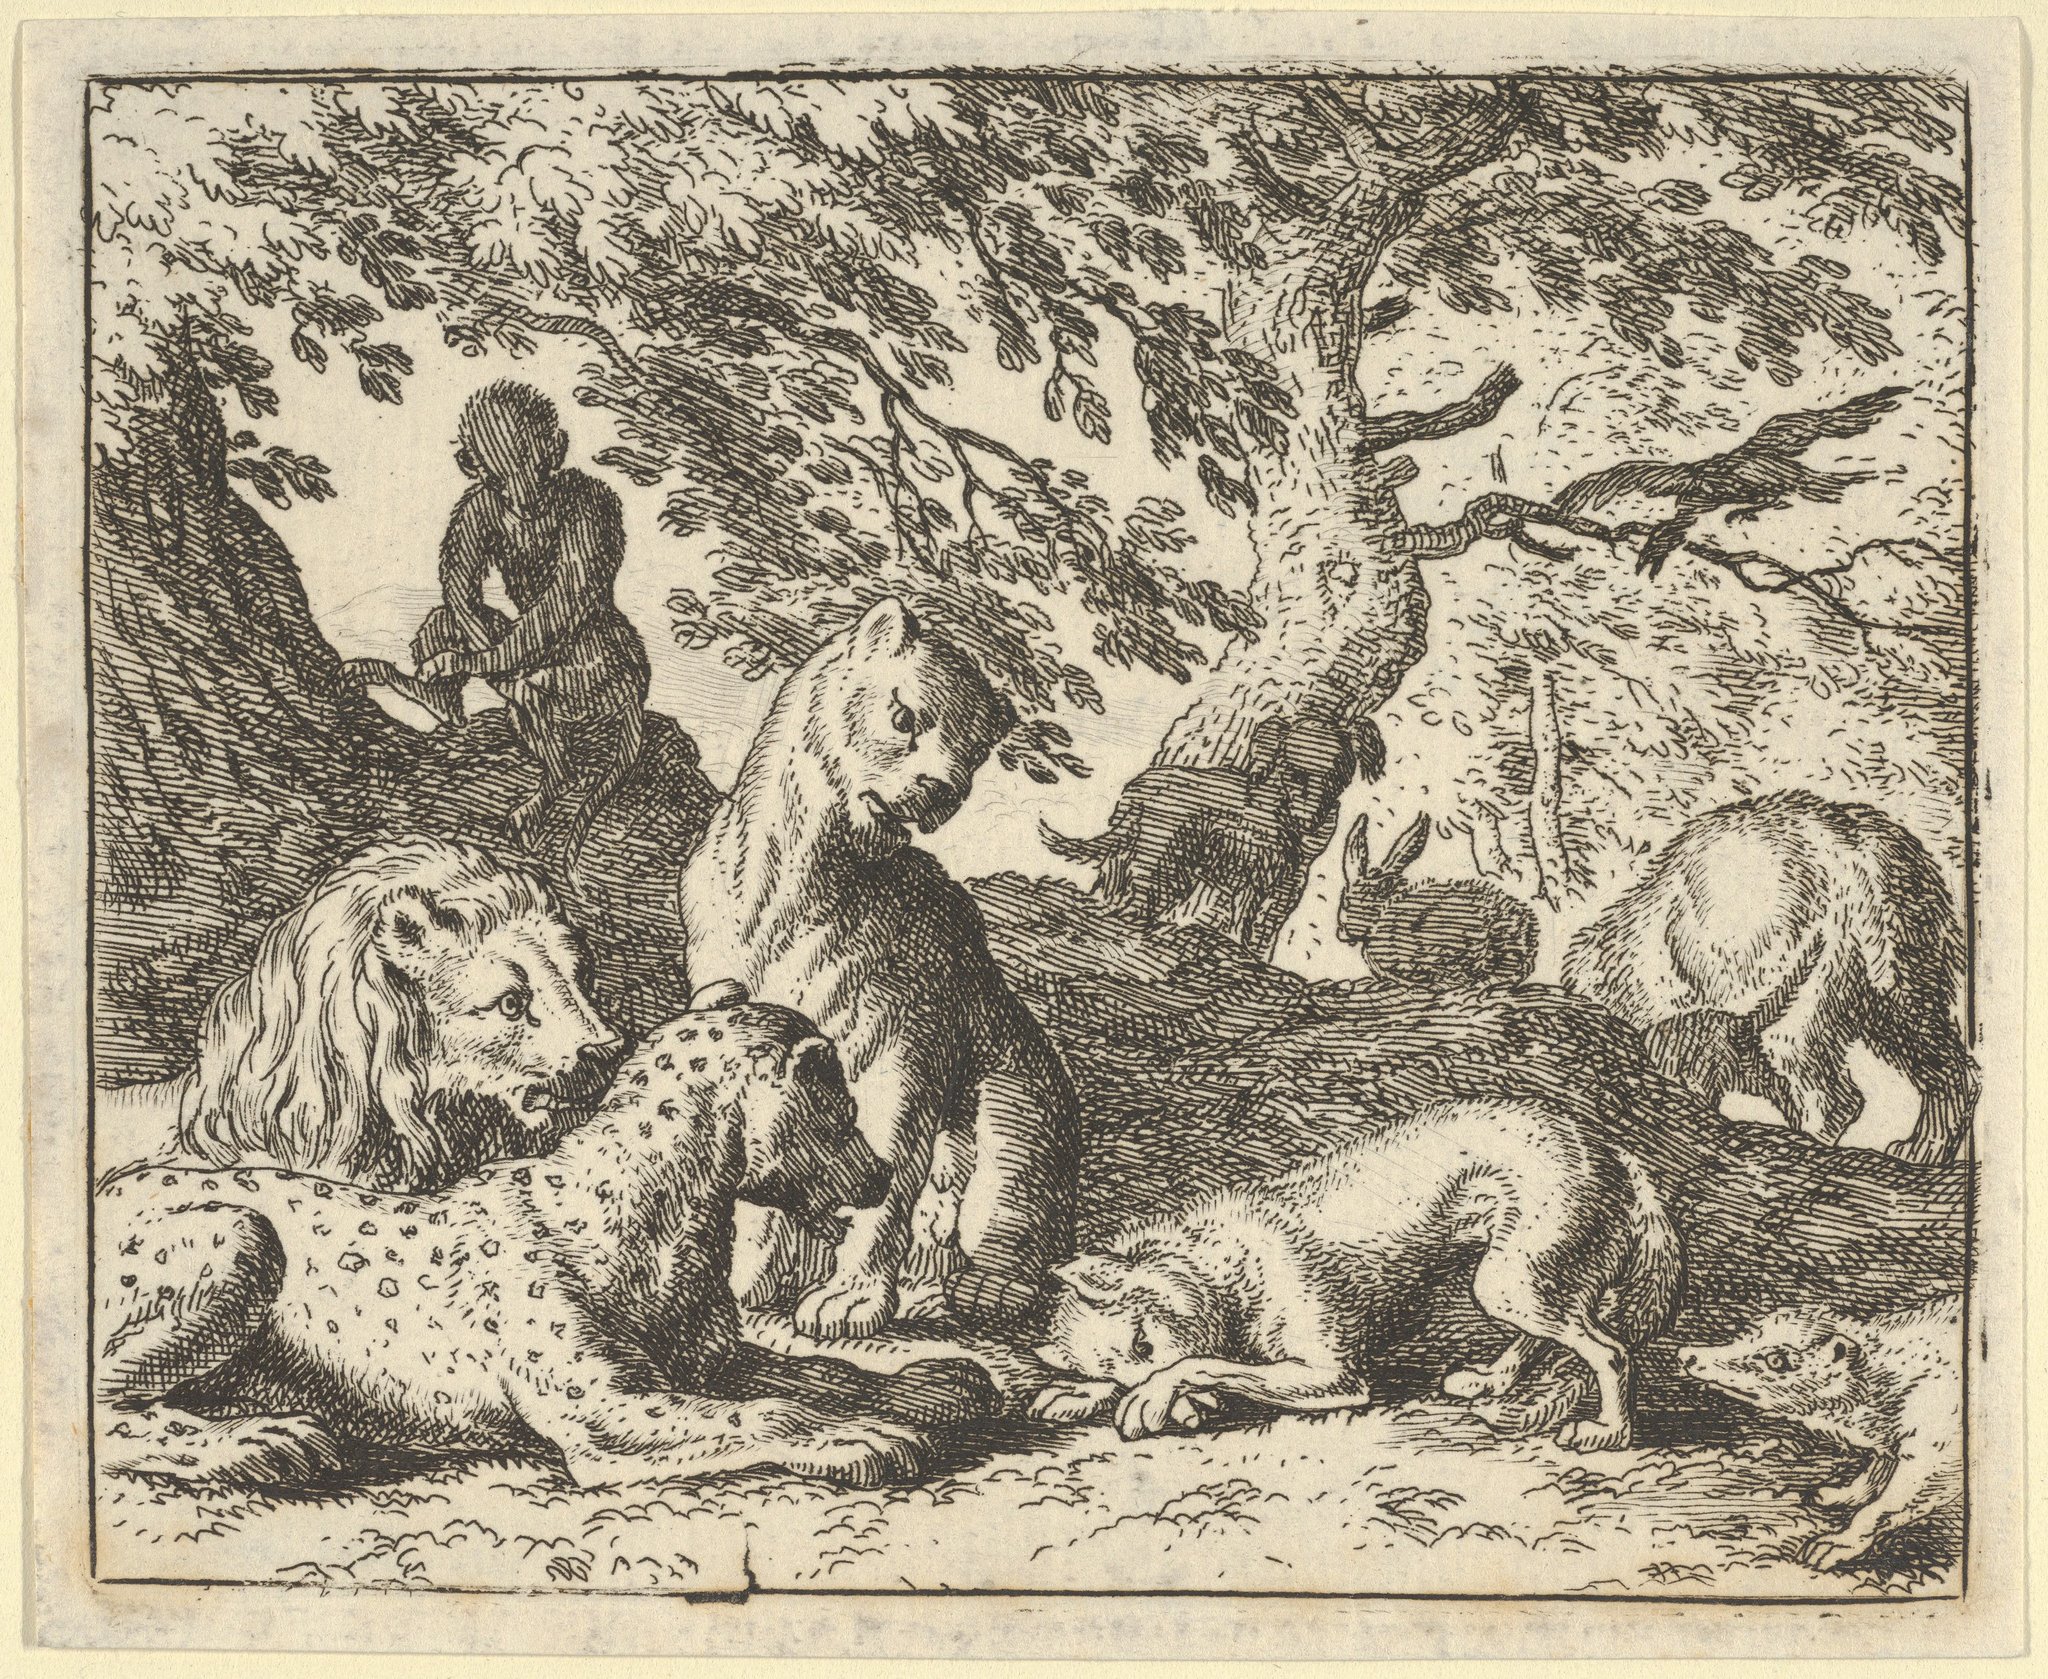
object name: print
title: Renard Falsely Accuses His Father of Conspiring Against the Lion from Hendrick van Alcmar's Renard The Fox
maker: allart van everdingen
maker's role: artist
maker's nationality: dutch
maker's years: 1621-1675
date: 1650-1675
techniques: engraving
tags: birds,foxes,lions,rabbits